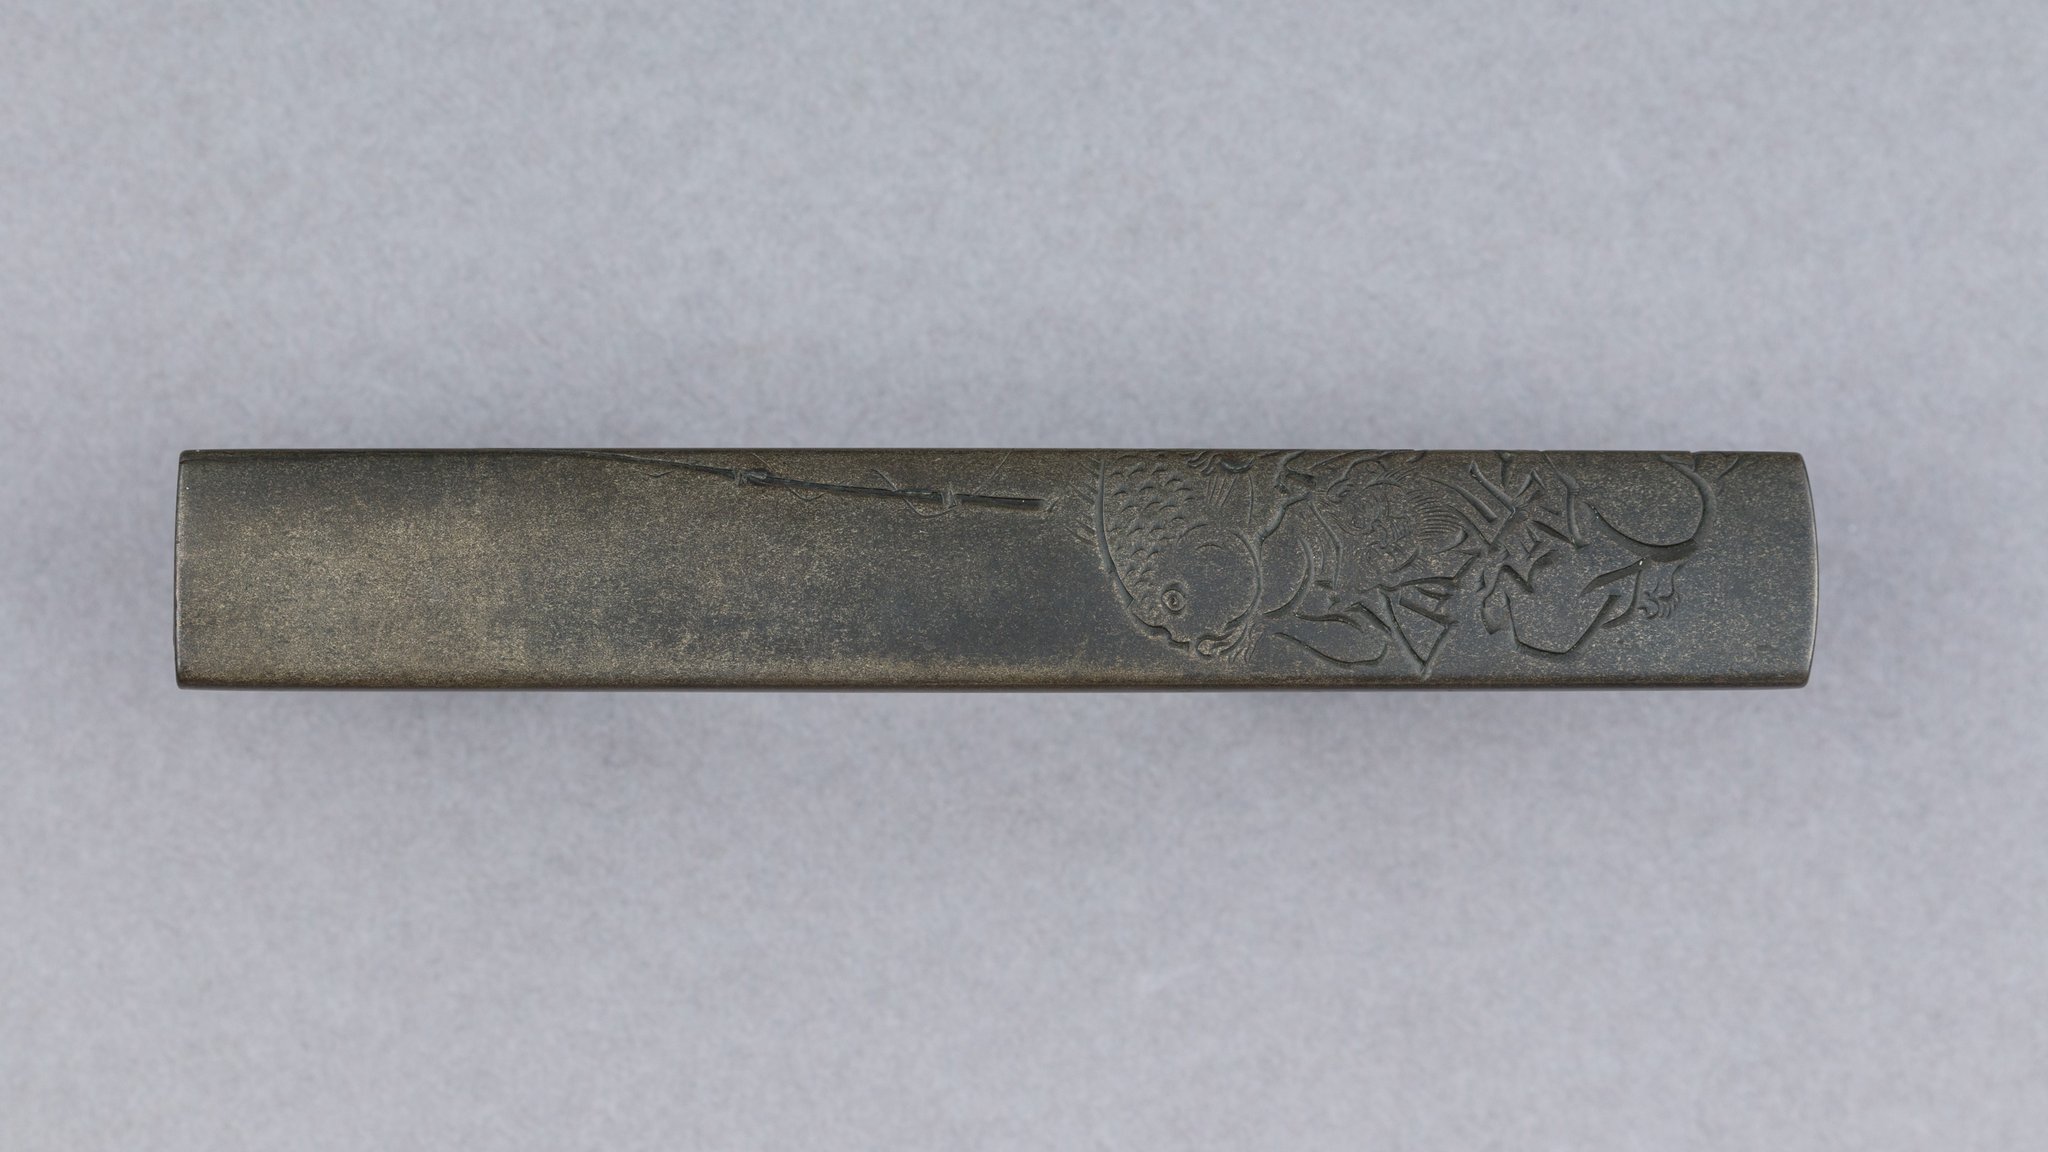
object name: knife handle kozuka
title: Knife Handle (Kozuka)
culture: japanese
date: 1701-1800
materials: silver alloy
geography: japan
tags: men,fish